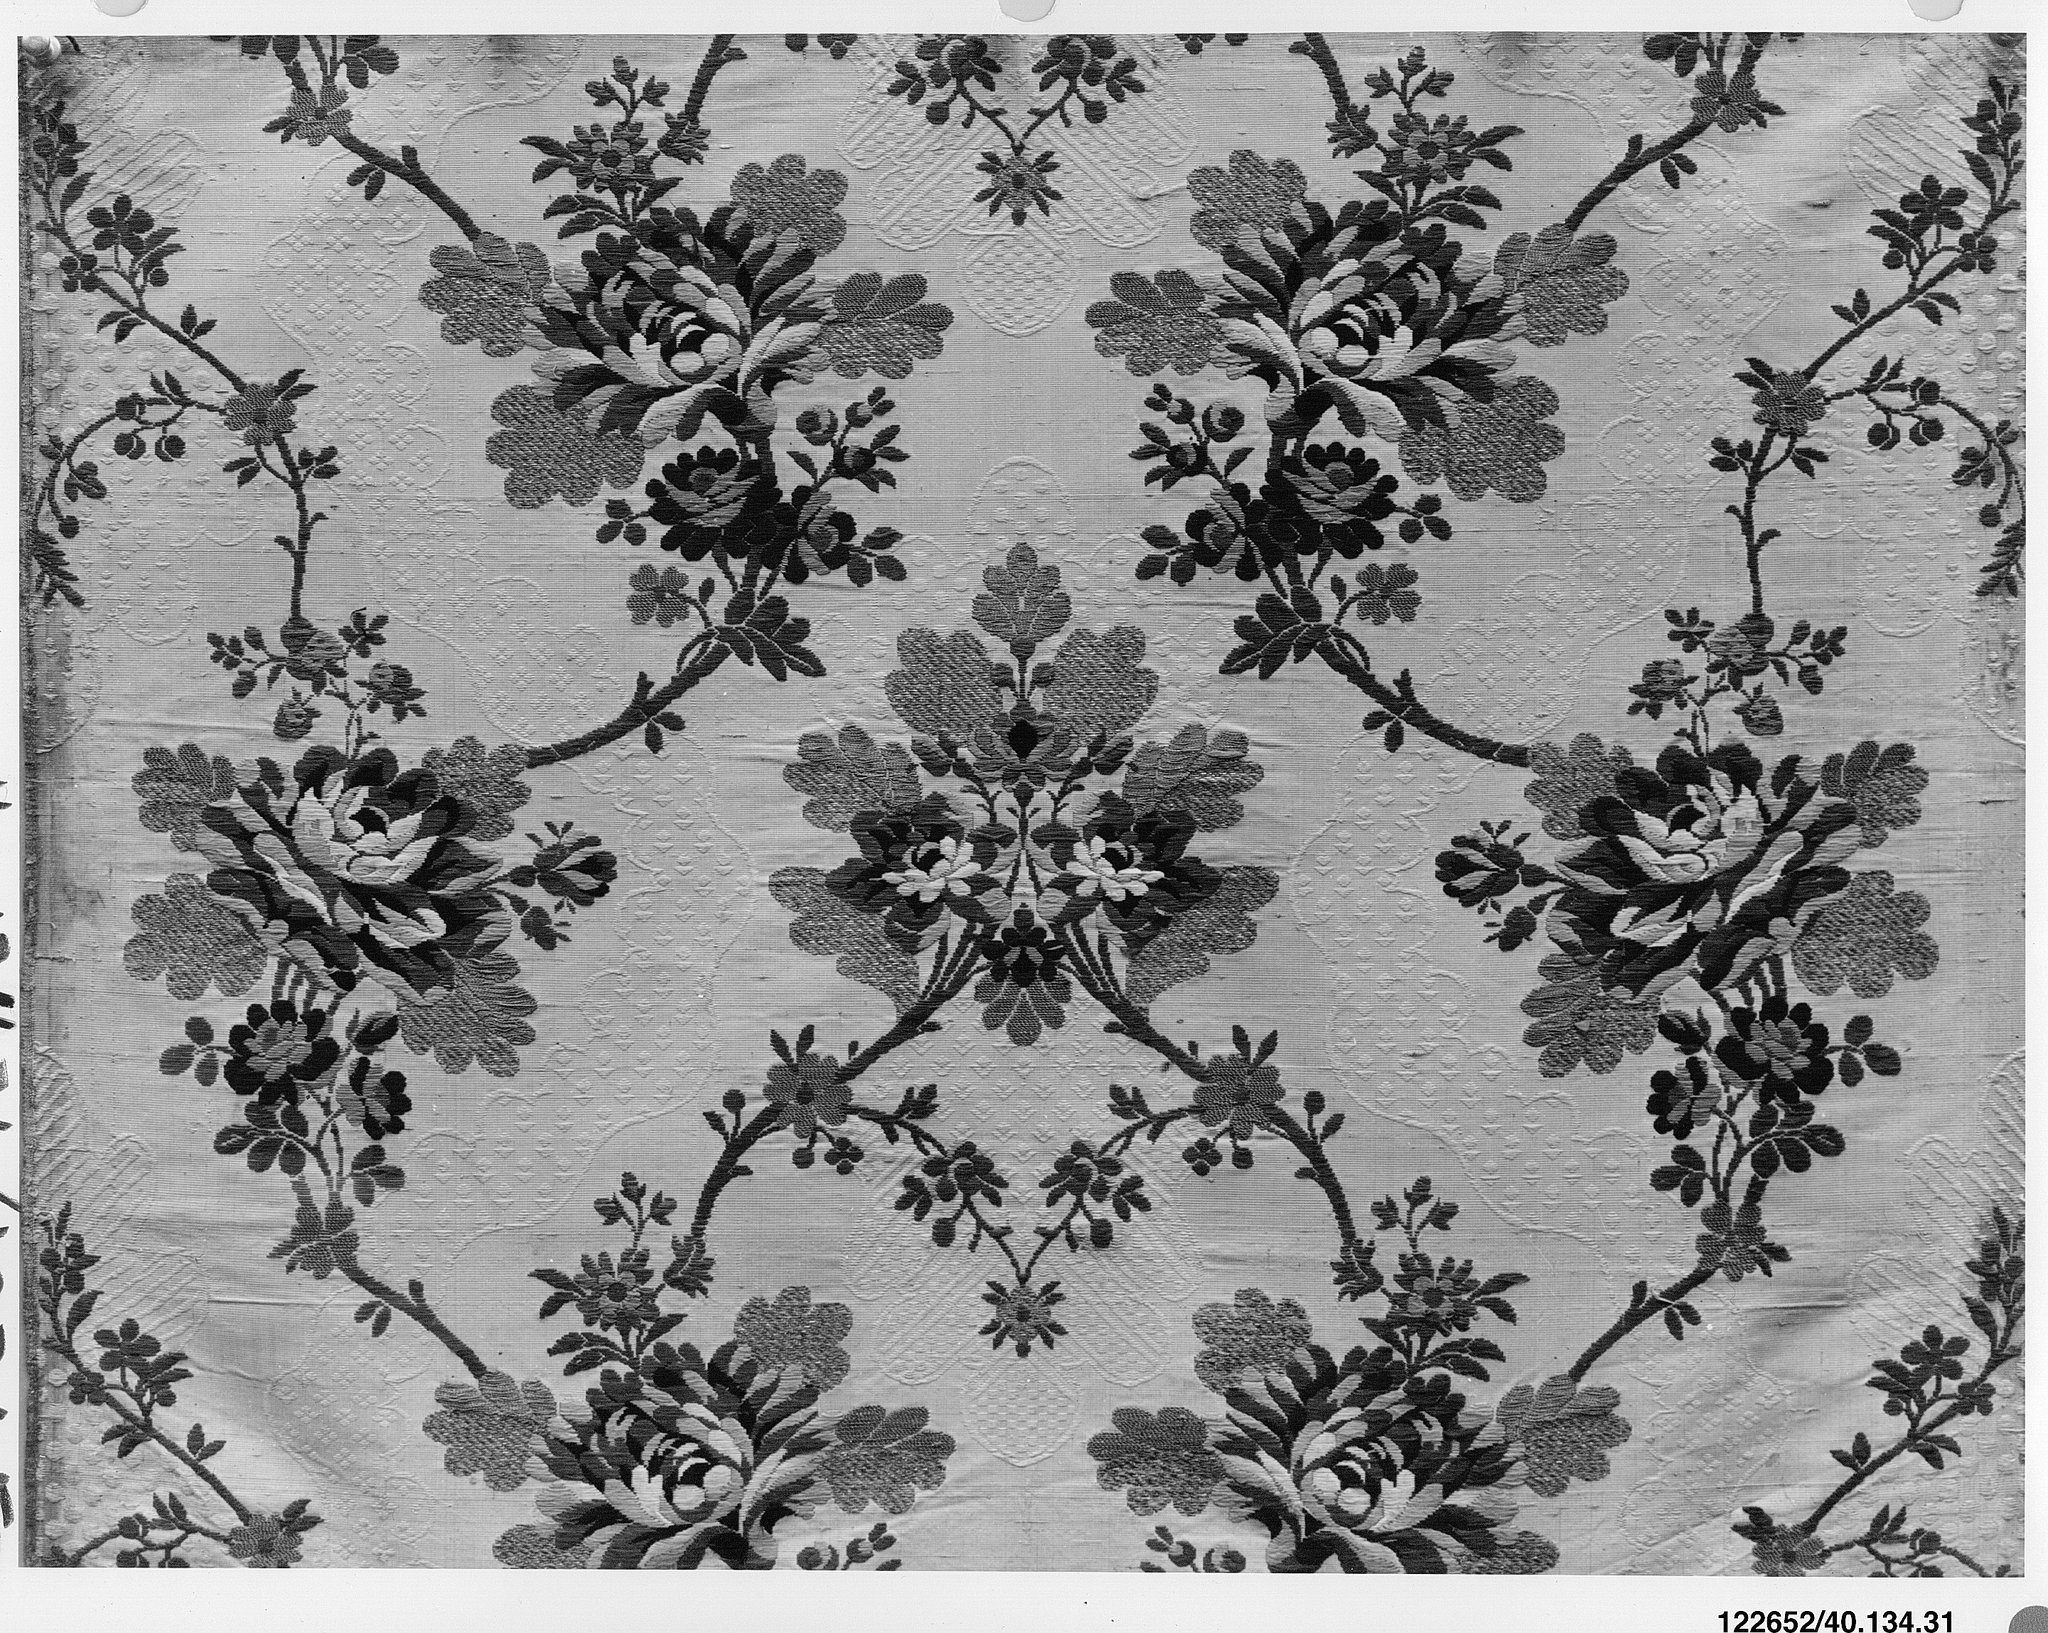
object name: piece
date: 1801-1833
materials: metal thread, silk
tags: flowers,leaves